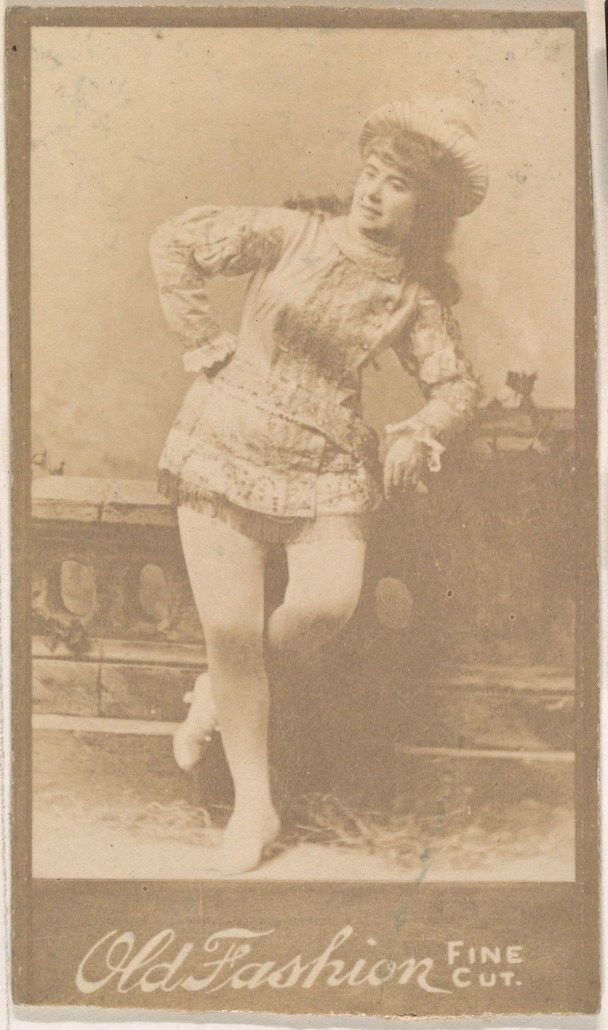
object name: photograph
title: Actress leaning on ballustrade, from the Actresses series (N664) promoting Old Fashion Fine Cut Tobacco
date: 1888-1890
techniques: albumen silver print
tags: portraits,women,actresses